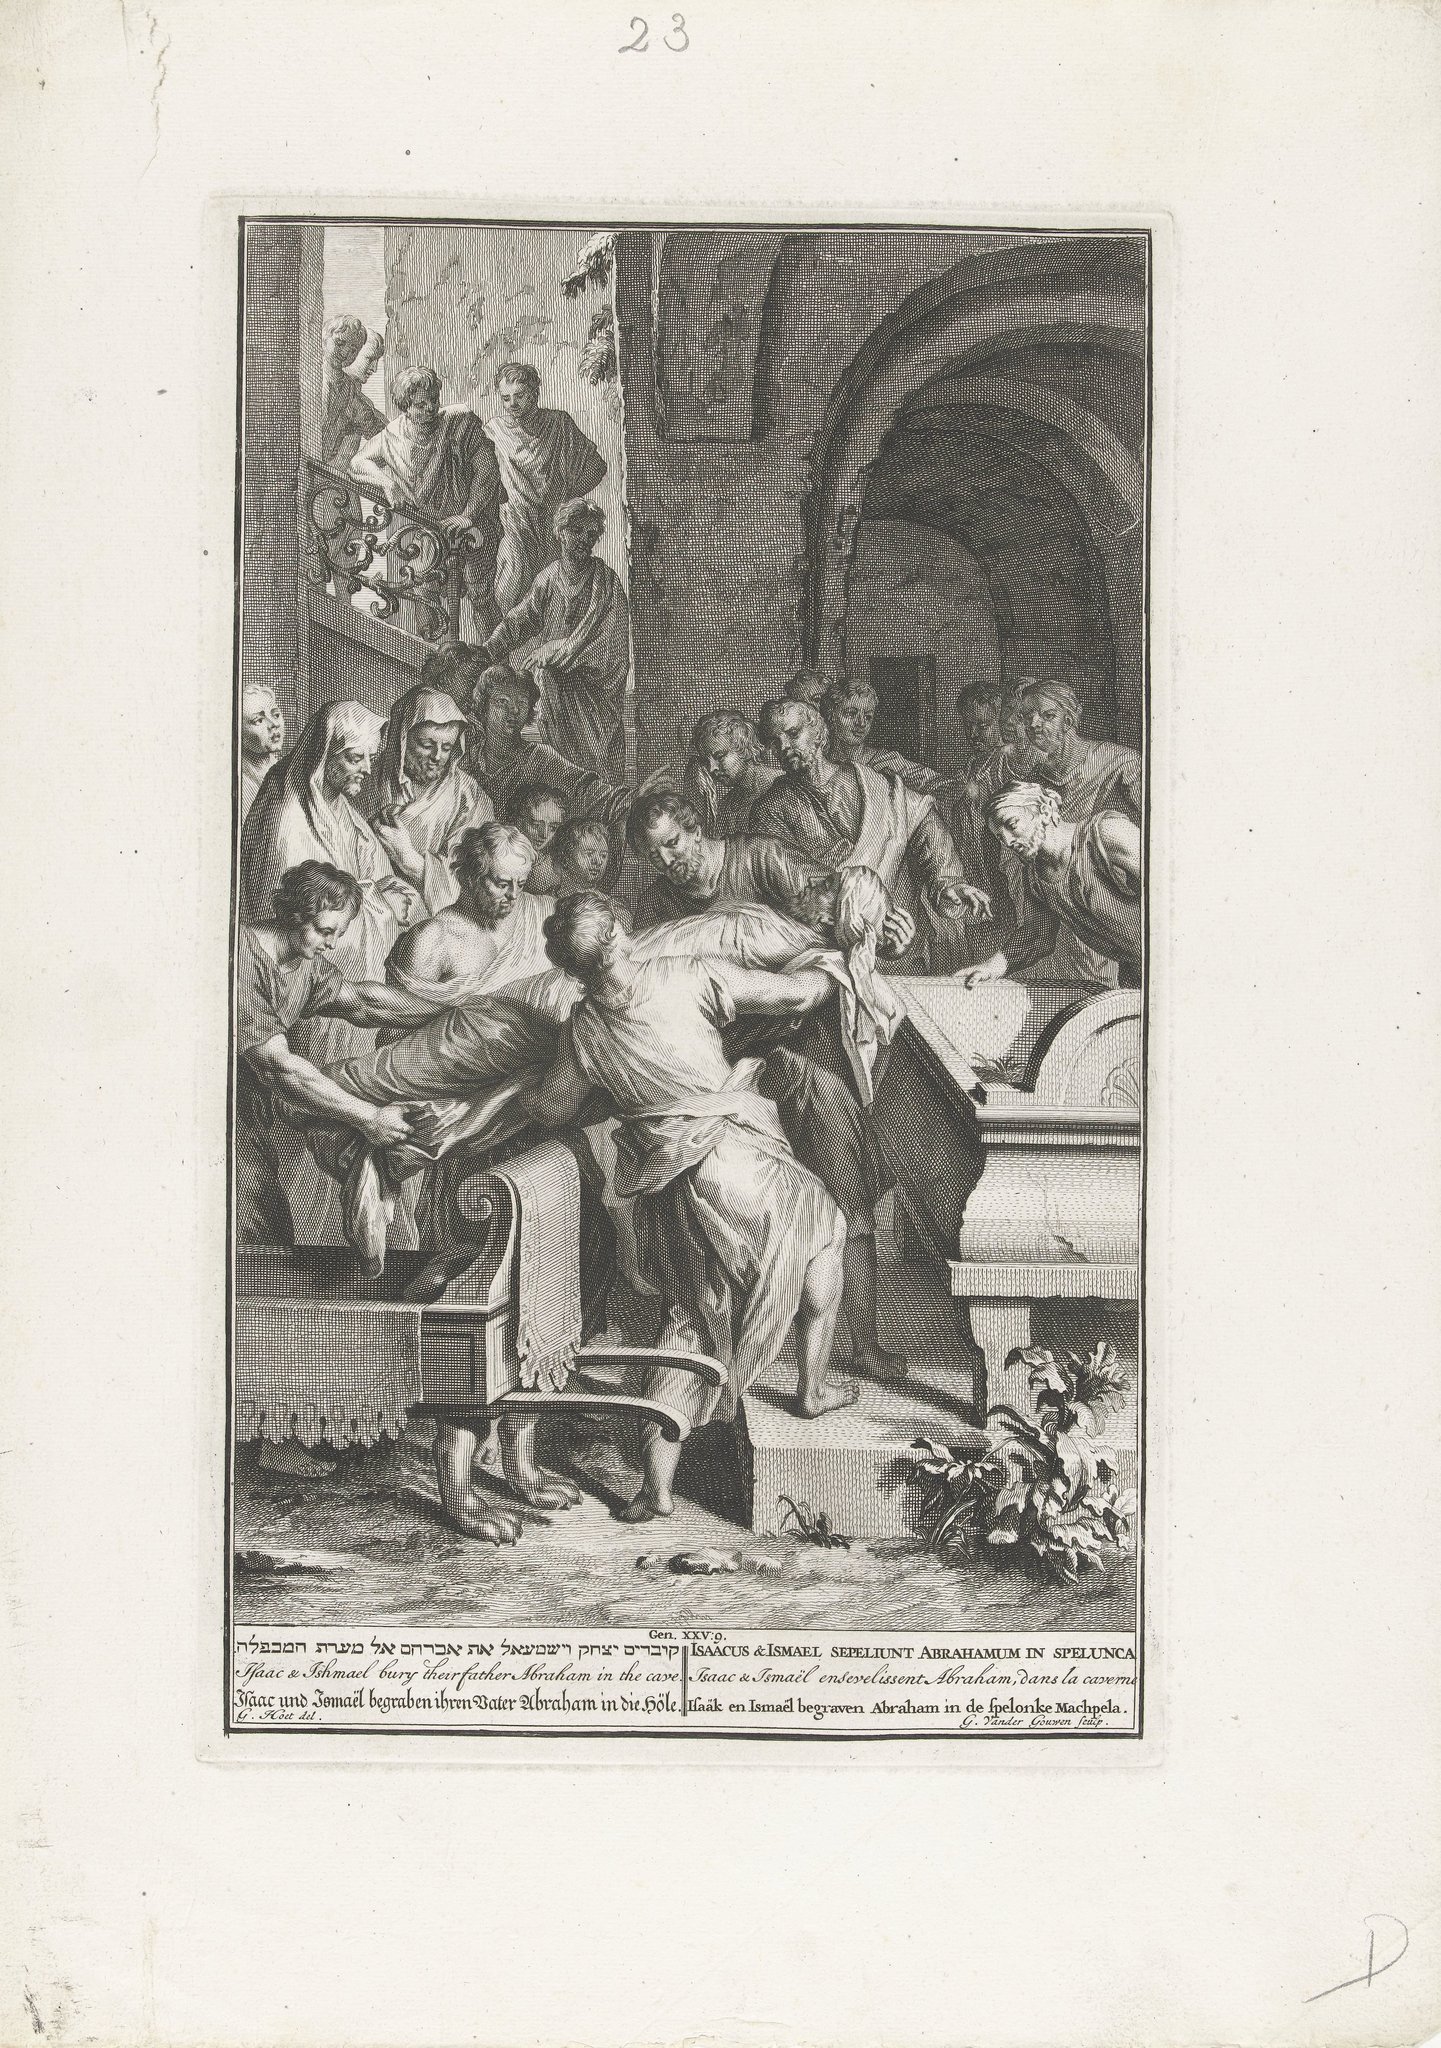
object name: print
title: Begrafenis van Abraham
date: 1728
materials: paper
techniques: engraving, etching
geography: the hague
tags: abraham is buried by isaac and ishmael in the cave of machpelah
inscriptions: collector's mark: Lugt 2228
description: Isaak en Ismaël begraven hun vader Abraham in de grot van Machpela op het land van Efron (Gen. 25:9). De prent heeft een Hebreeuws, Latijns, Frans, Engels, Duits en Nederlands onderschrift.